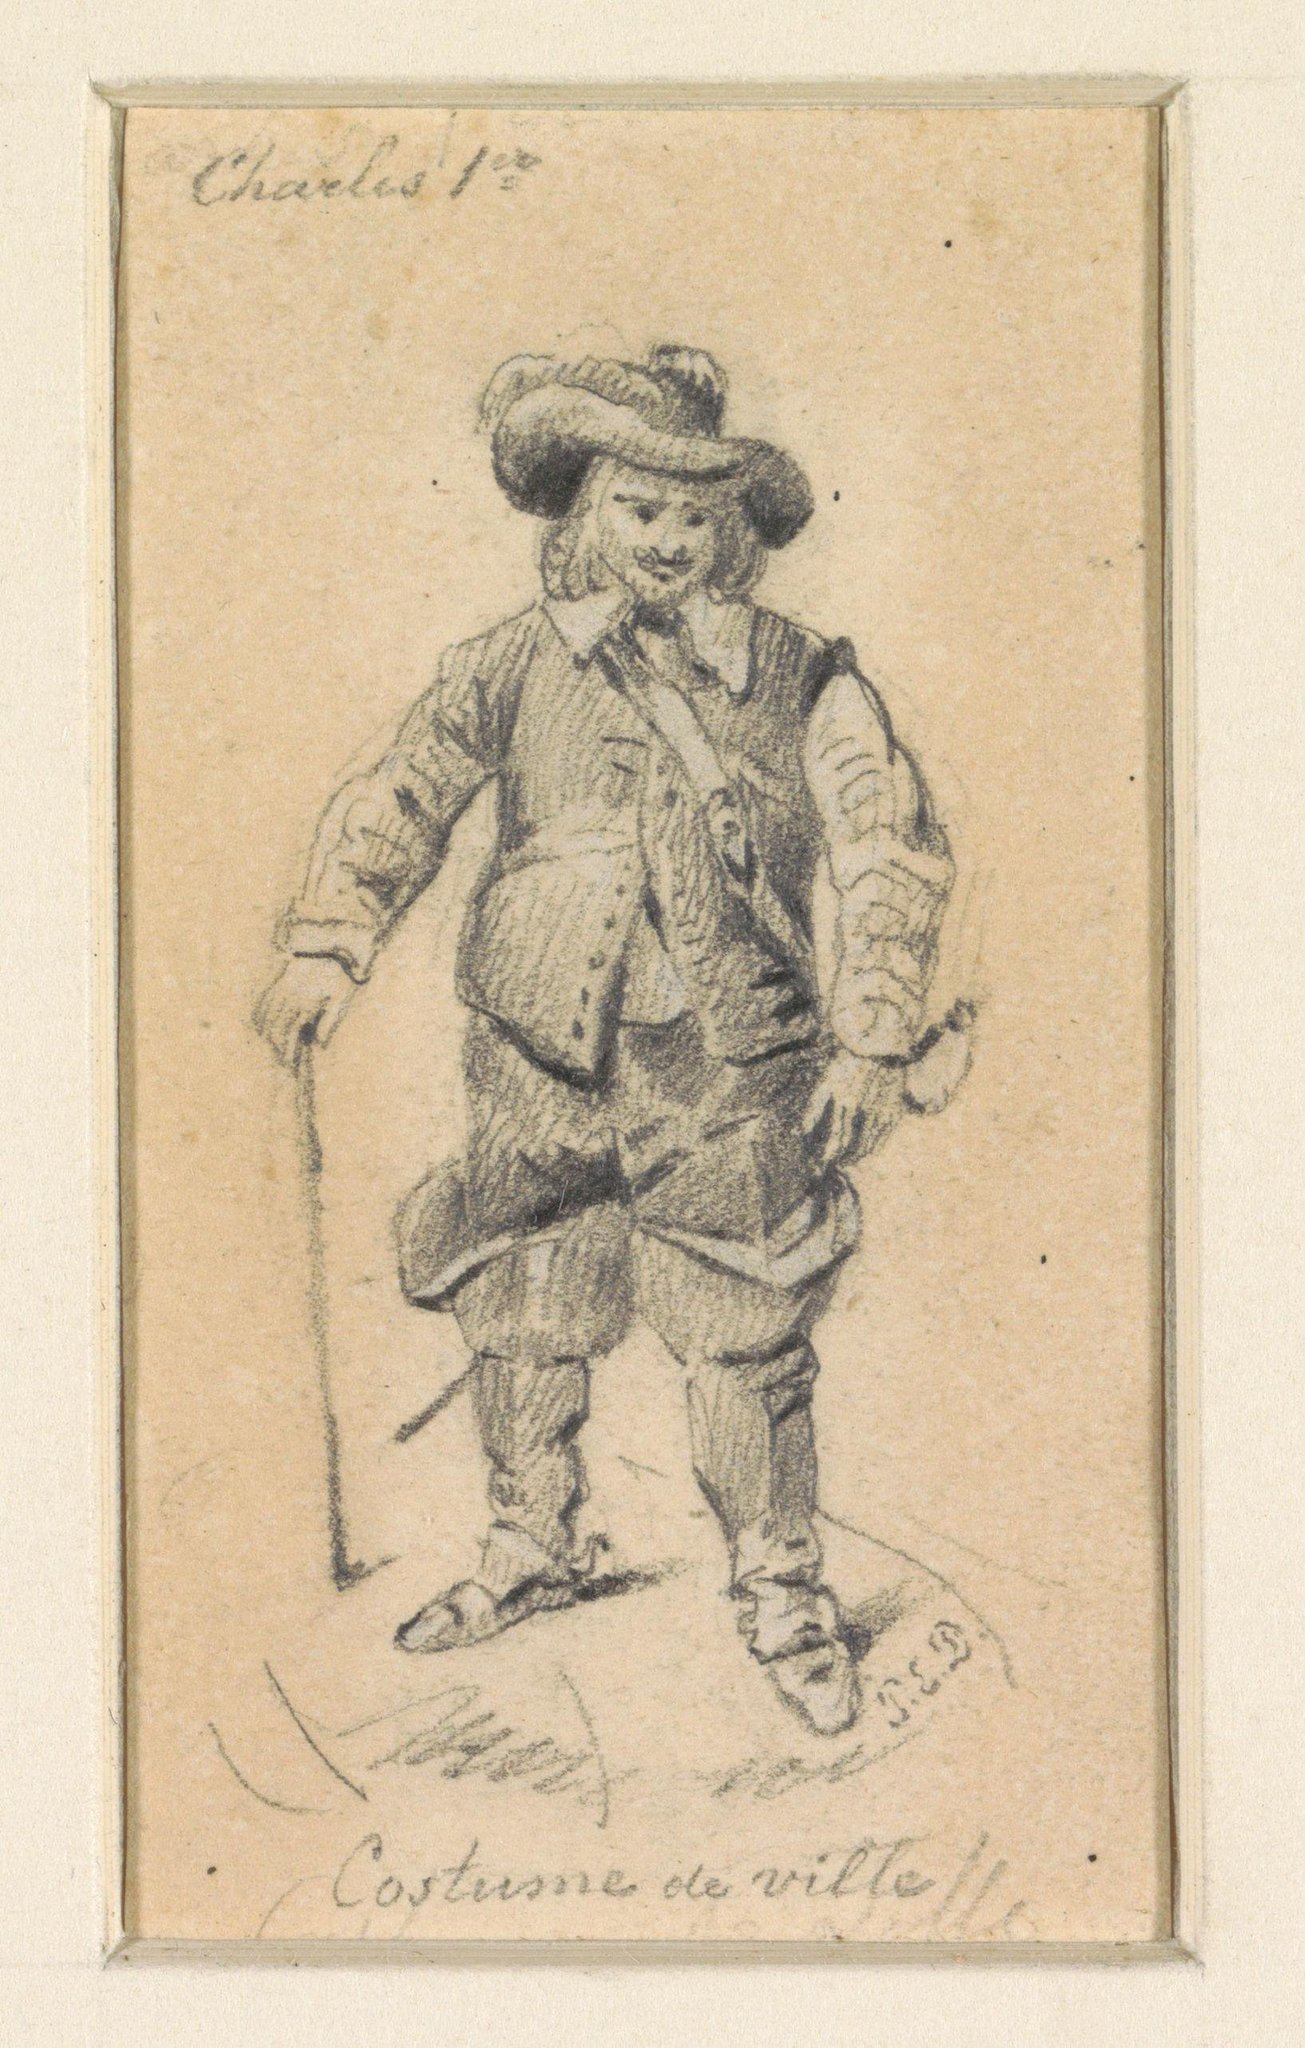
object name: drawing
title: Kostuumstudie van staande ridder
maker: pierre emmanuel dielman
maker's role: draughtsman, painter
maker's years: 1800-1858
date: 1810-1858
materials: paper, pencil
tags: historical costume, (military) uniforms